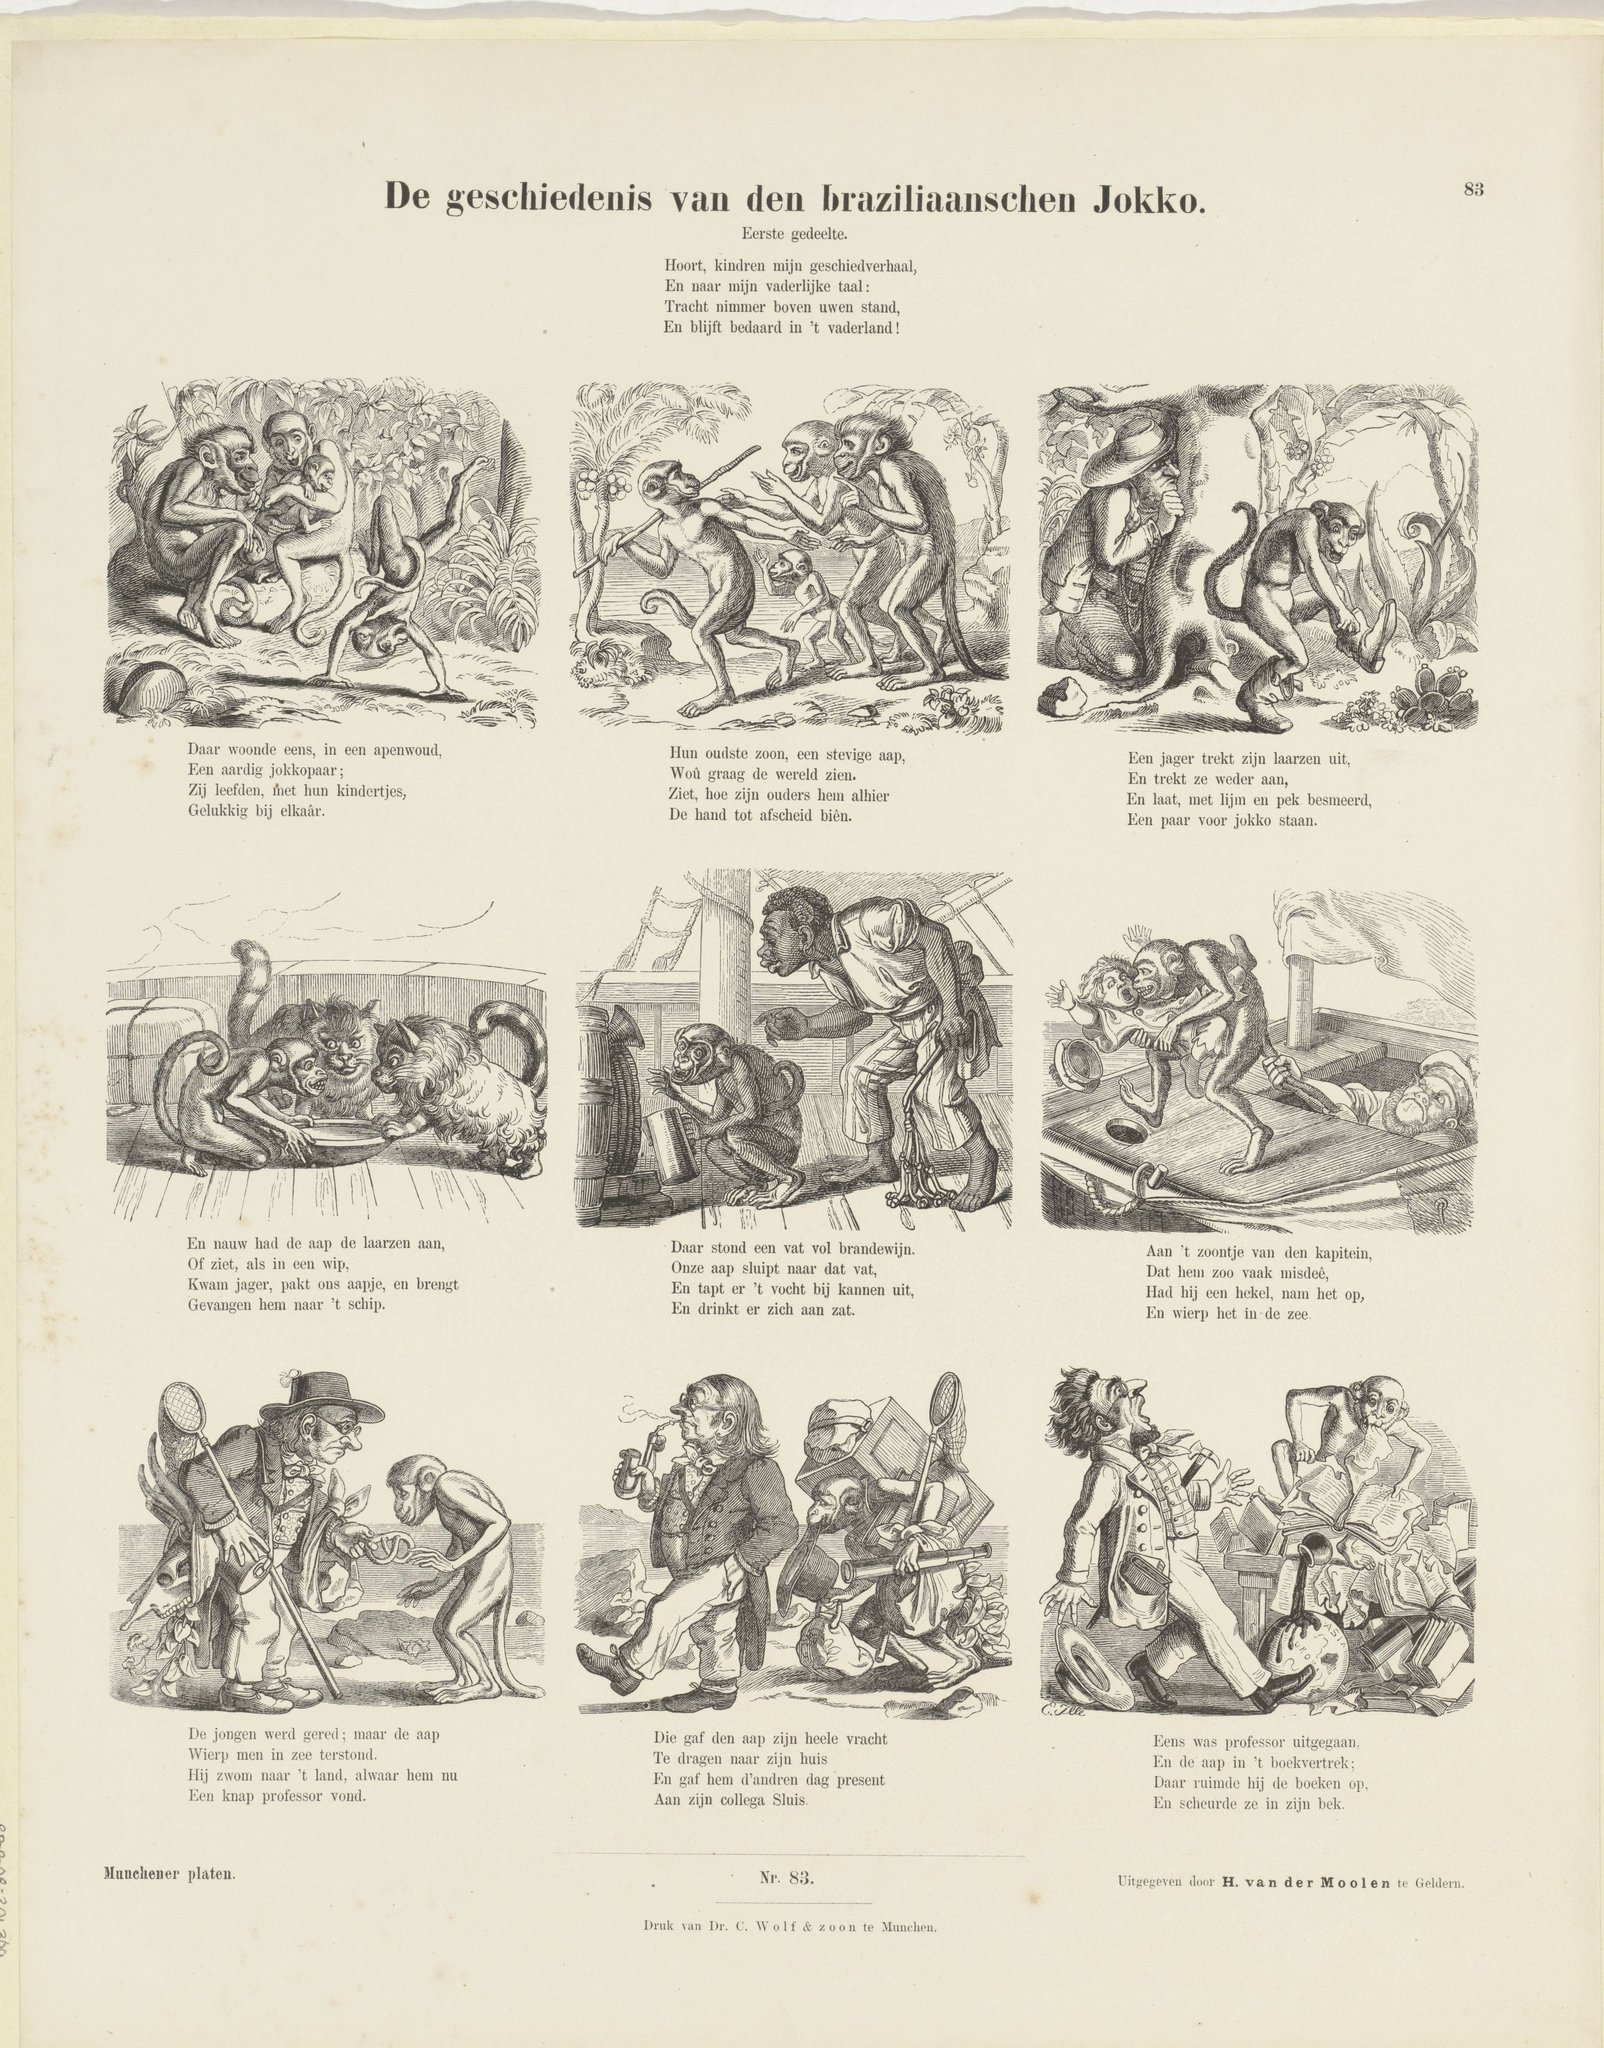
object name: popular print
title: Munchener platen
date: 1843-1920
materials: paper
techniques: letterpress printing, engraving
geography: geldern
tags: monkeys, apes, hunter, professor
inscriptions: collector's mark: Lugt 2760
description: Blad met 9 voorstellingen over de avonturen van het Braziliaanse aapje Jokko (eerste deel). Onder elke afbeelding een vierregelig vers. Genummerd midden onder: Nro. 83. Genummerd rechtsboven: 83.